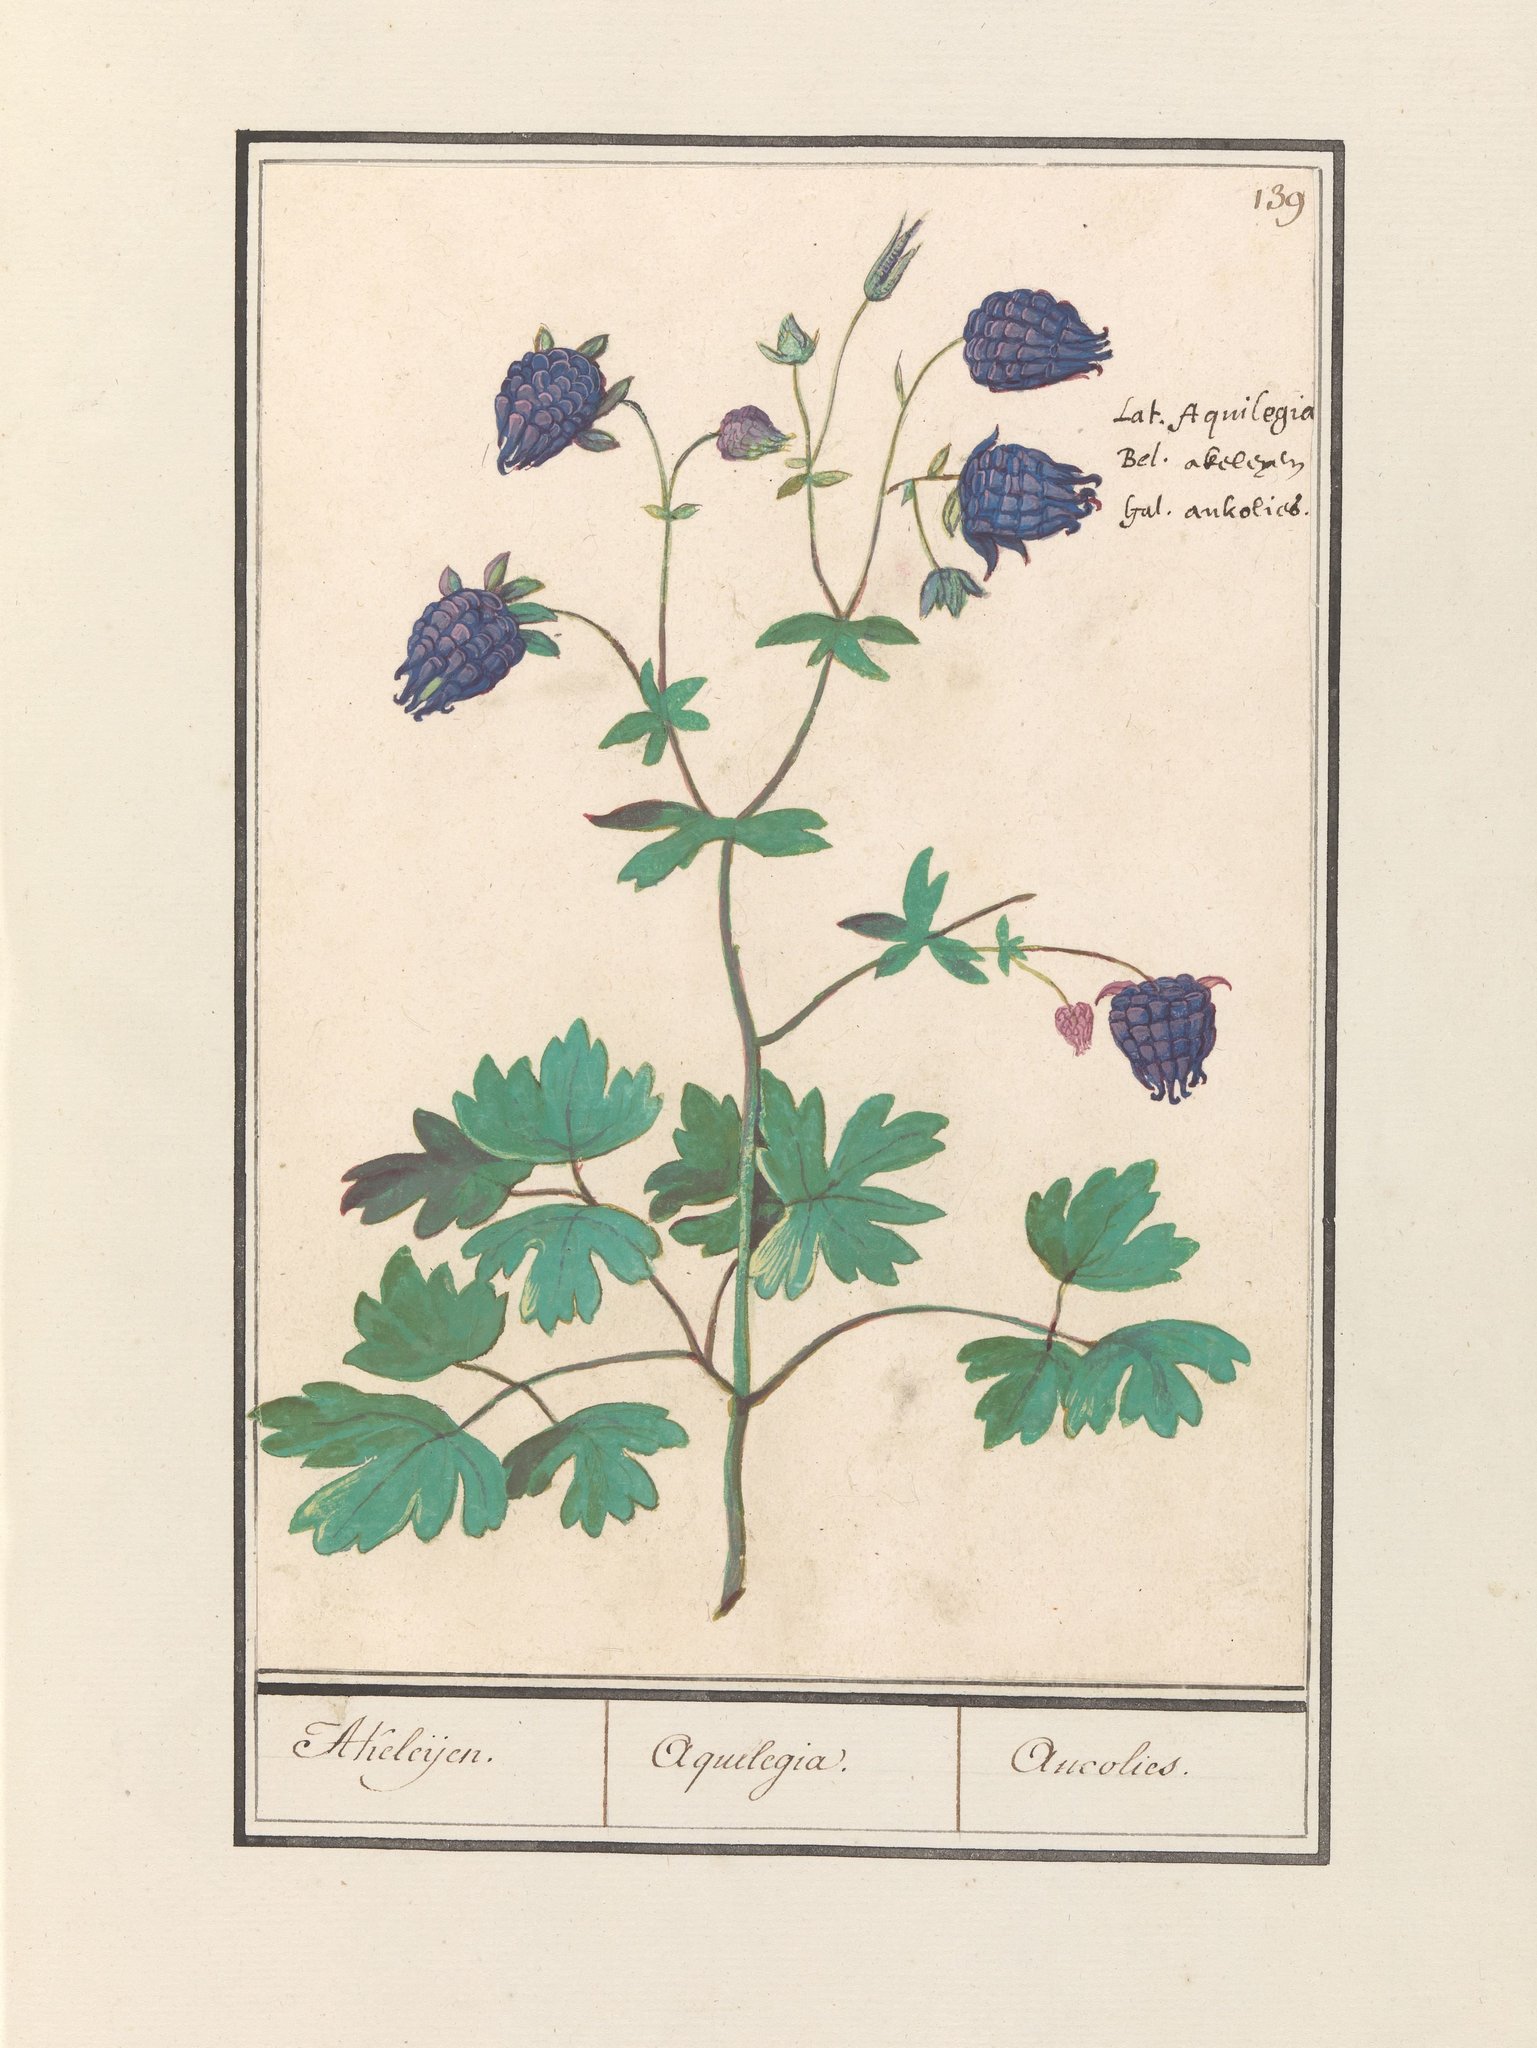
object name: drawing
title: Akelei (Aquilegia)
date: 1596-1610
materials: chalk, paint, ink, paper, watercolor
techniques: brush, pen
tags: flowers: columbine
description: Akelei. Rechtsboven genummerd: 139. Rechtsboven de naam in drie talen. Onderdeel van het tweede album met tekeningen van bloemen en planten. Negende van twaalf albums met tekeningen van dieren, vogels en planten bekend rond 1600, gemaakt in opdracht van keizer Rudolf II. Met toelichting in Nederlands, Latijn en Frans.